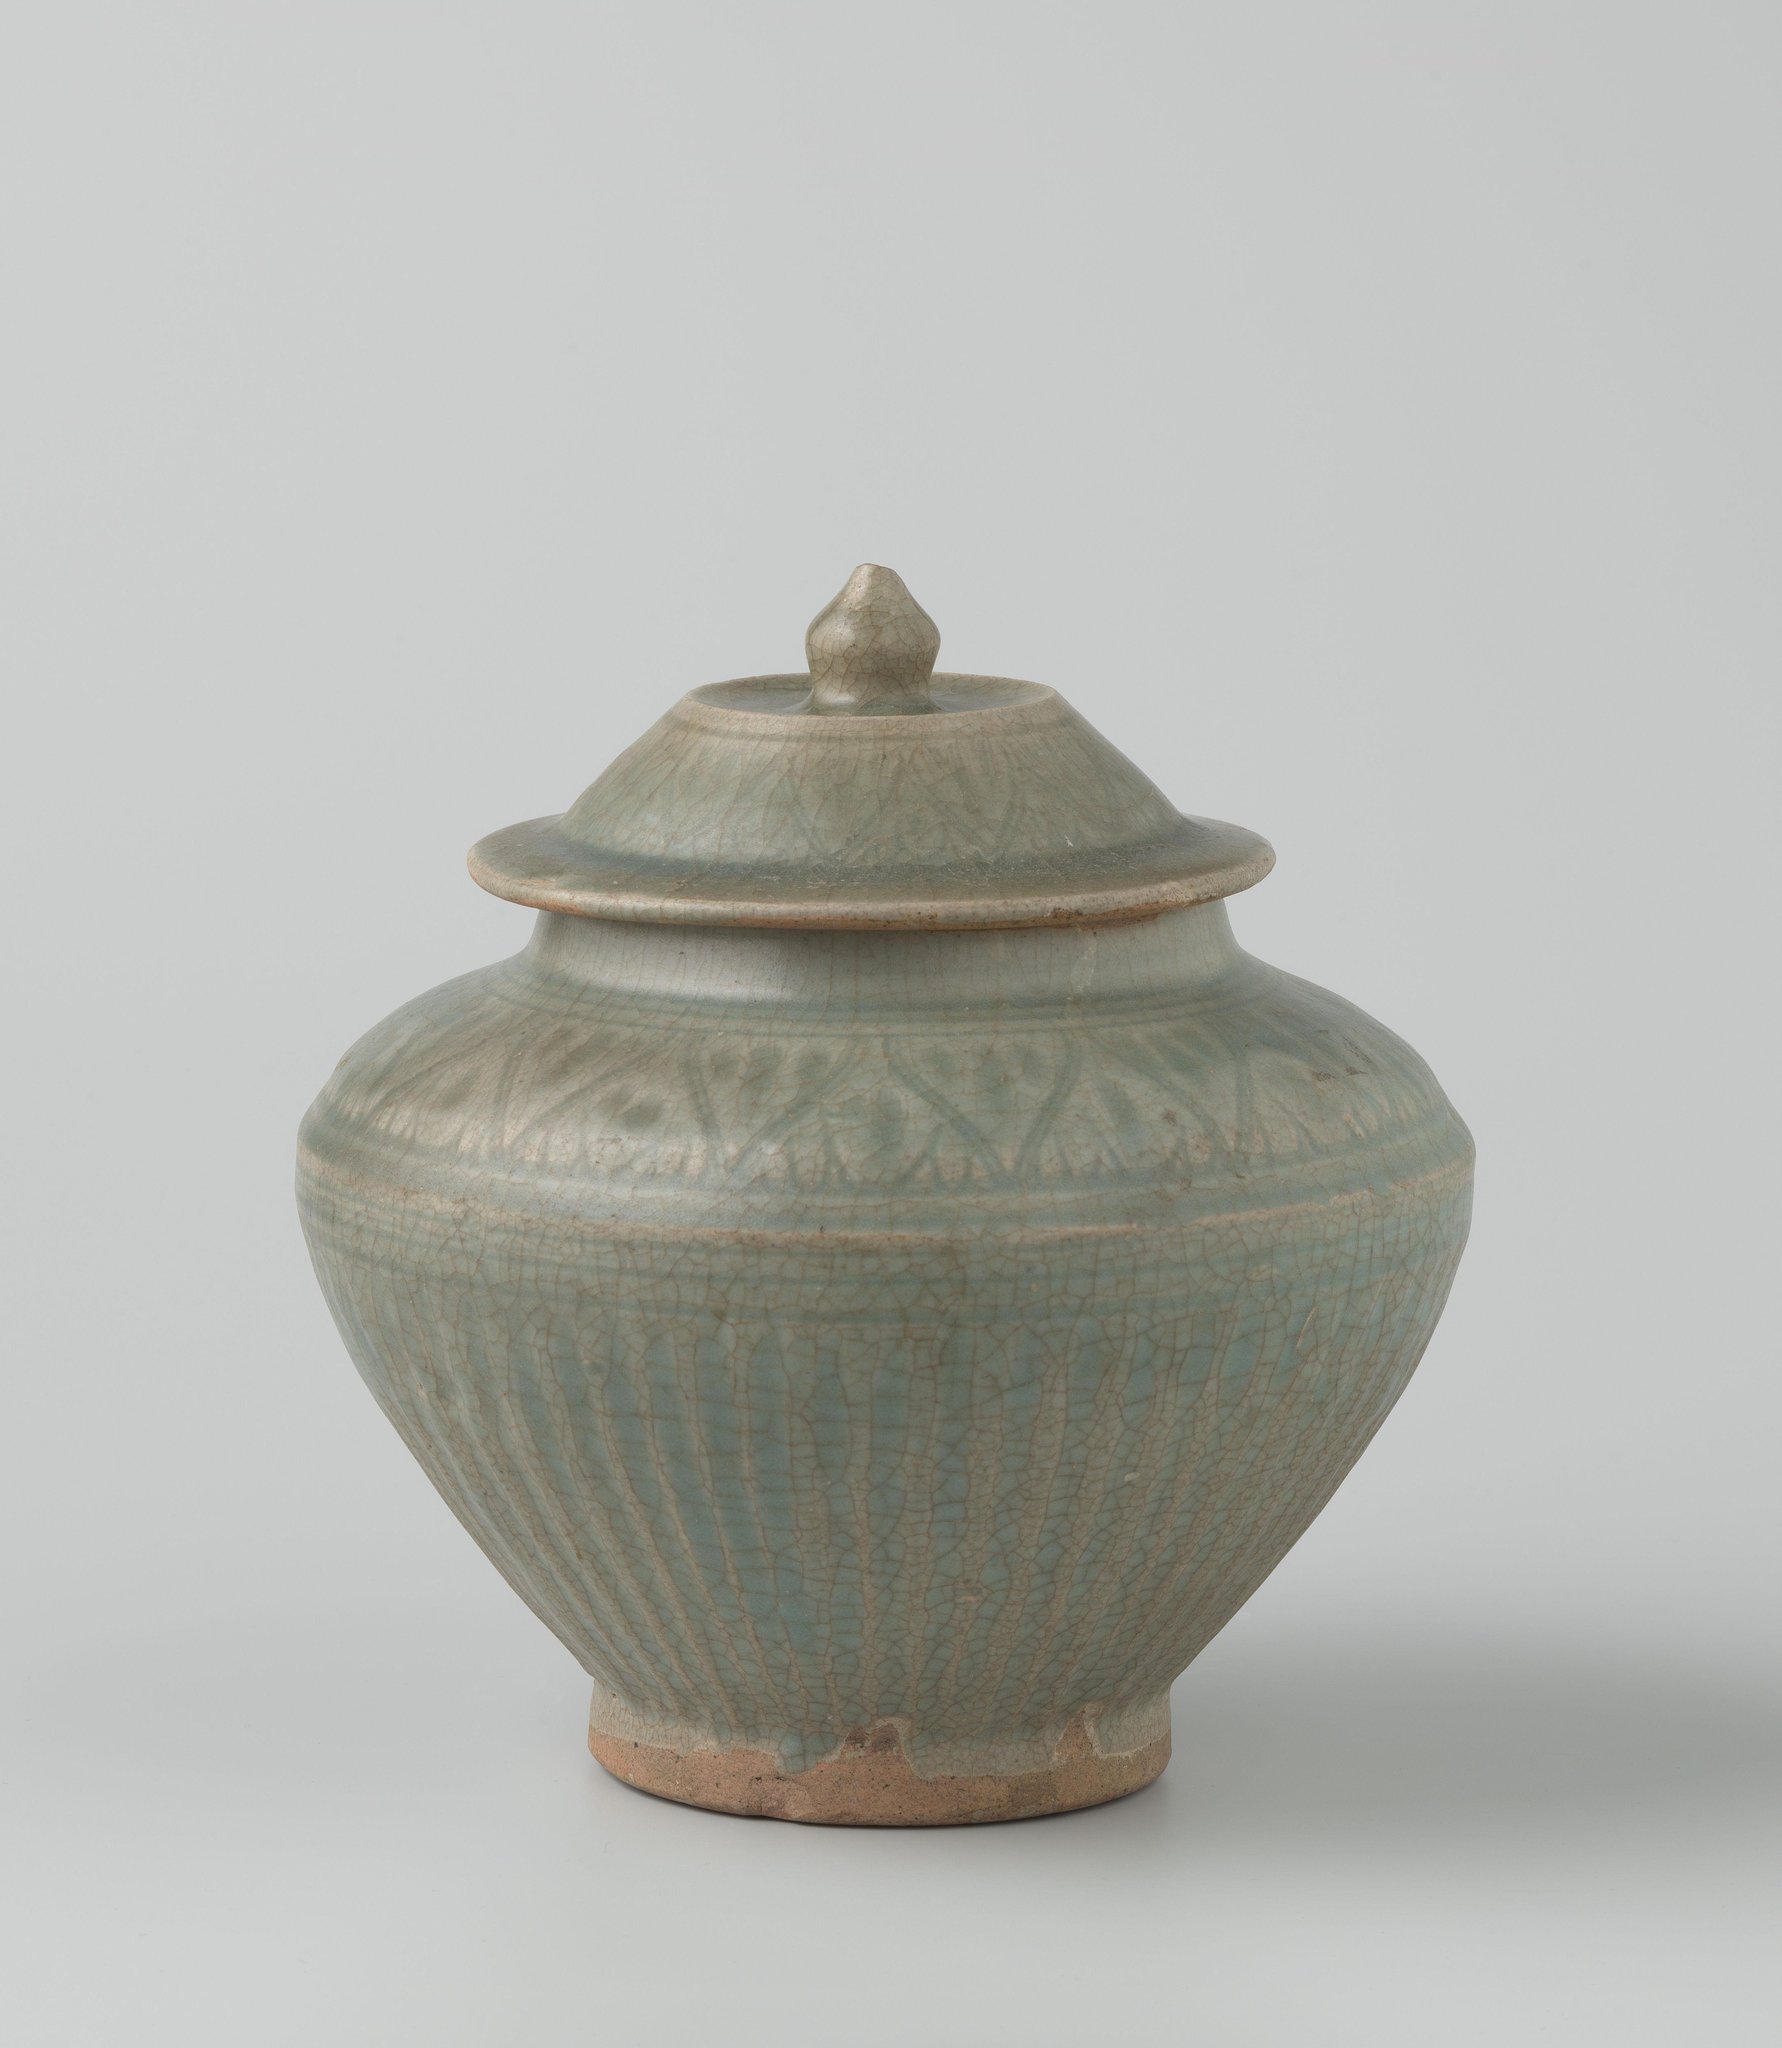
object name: pot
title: Dekselpot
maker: Anonymous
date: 1200-1499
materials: ceramic, earthenware, stoneware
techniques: vitrification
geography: sawankhalok